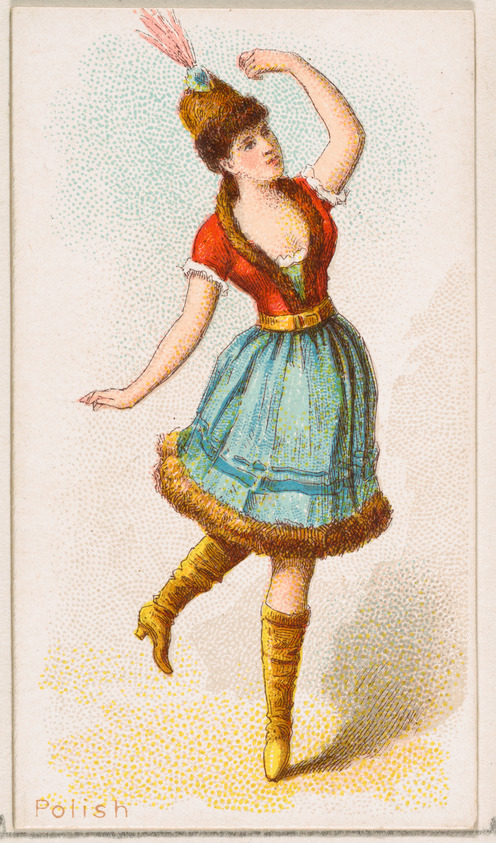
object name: print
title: Polish Dancer, from the Dancing Women series (N186) issued by Wm. S. Kimball & Co.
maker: william s. kimball & company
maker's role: publisher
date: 1889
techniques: color lithograph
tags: women,dancing,dancers